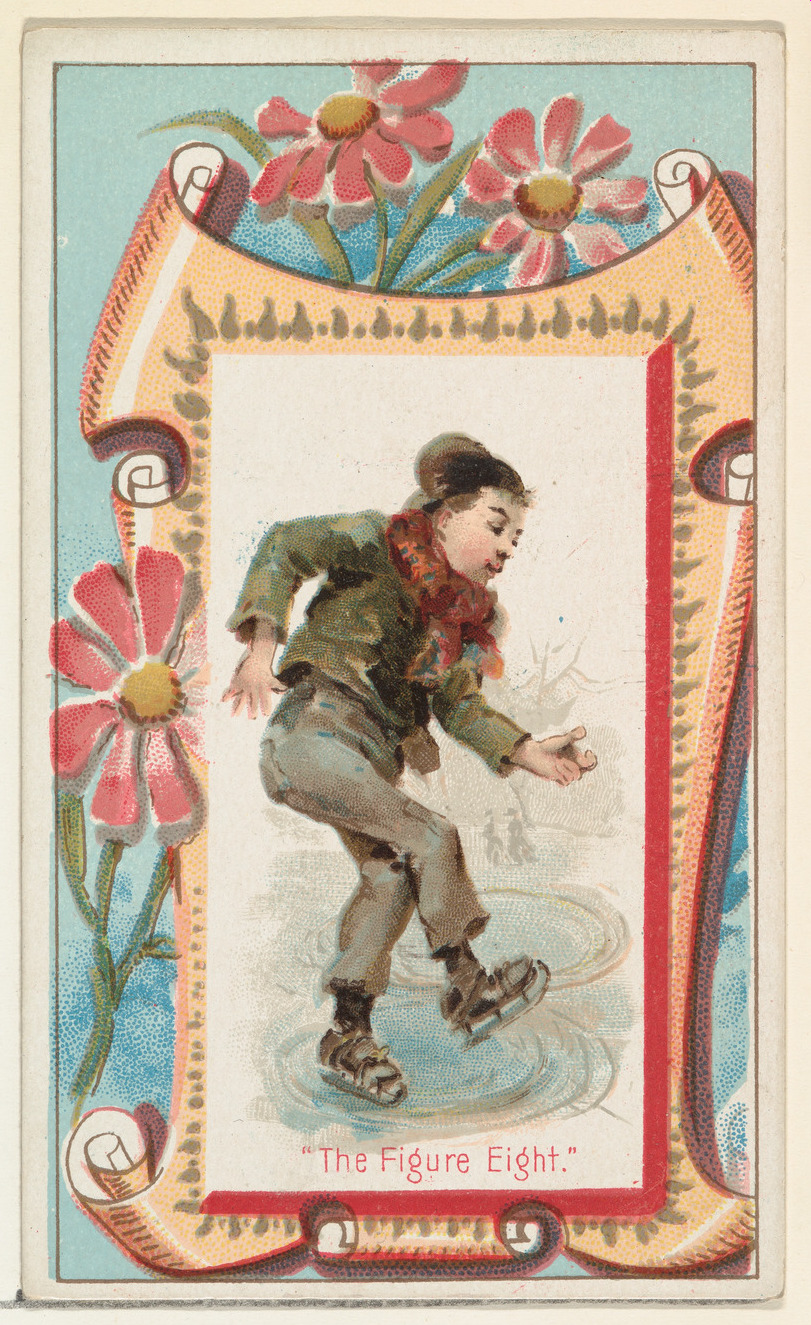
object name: print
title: "The Figure Eight," from the Terrors of America set (N136) issued by Duke Sons & Co. to promote Honest Long Cut Tobacco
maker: w. duke, sons & co.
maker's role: publisher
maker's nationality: american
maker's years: 1870-1920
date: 1888-1889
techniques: color lithograph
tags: boys,flowers